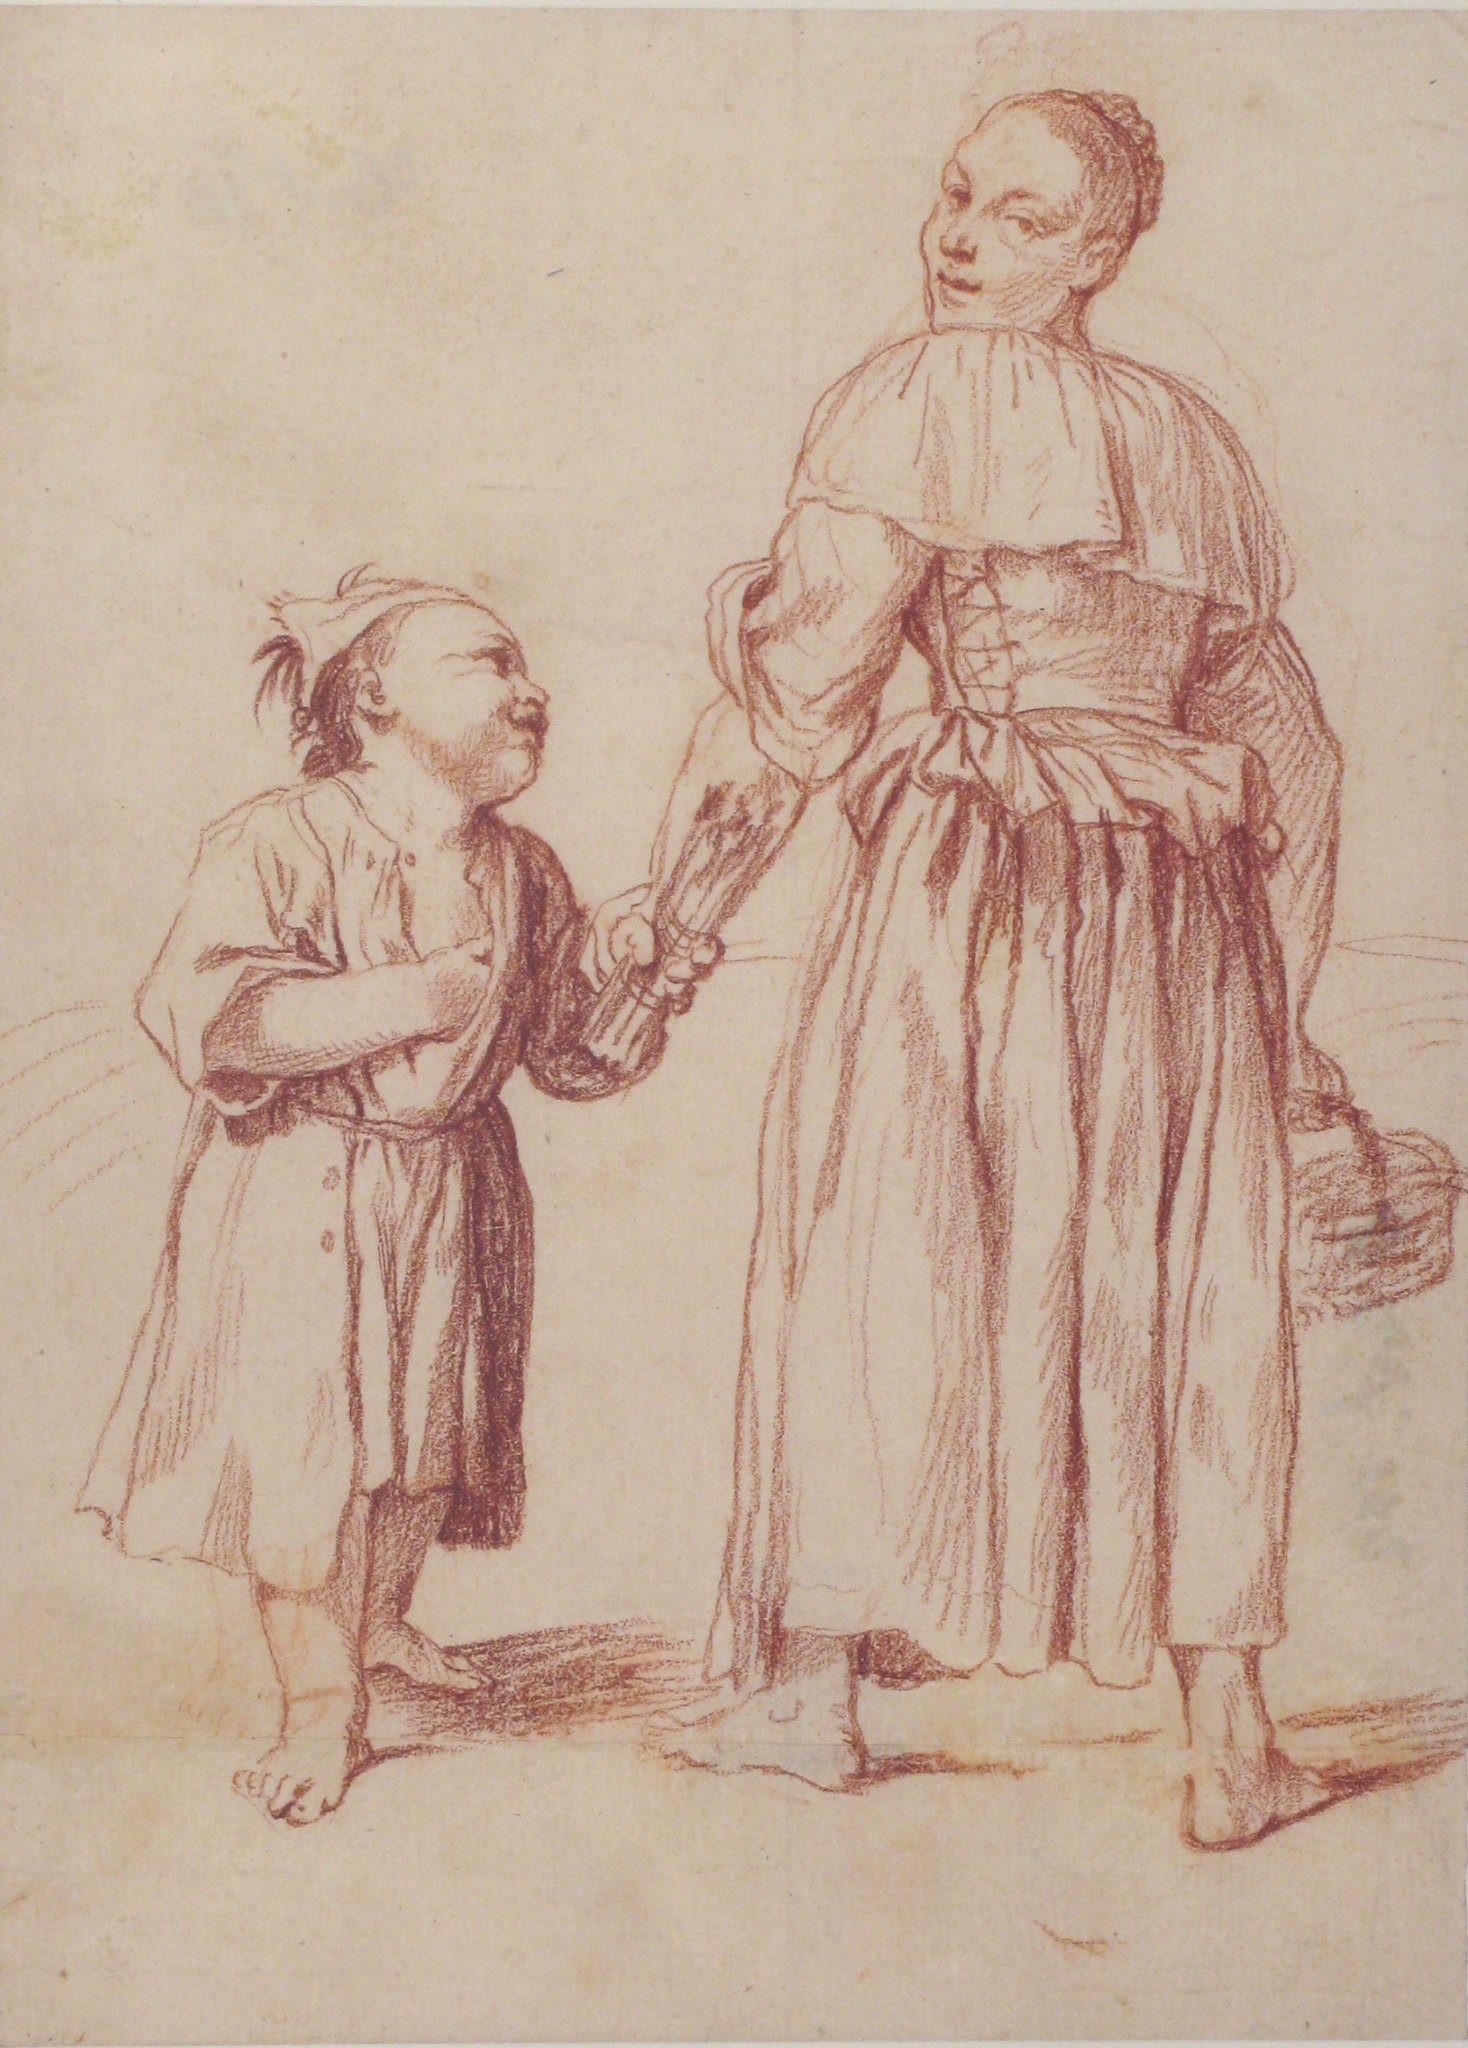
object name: drawing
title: Menghina Coming from the Garden Meets Cacasenno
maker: giuseppe maria crespi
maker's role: artist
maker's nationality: italian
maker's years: 1665-1747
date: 1665-1747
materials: chalk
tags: girls,women